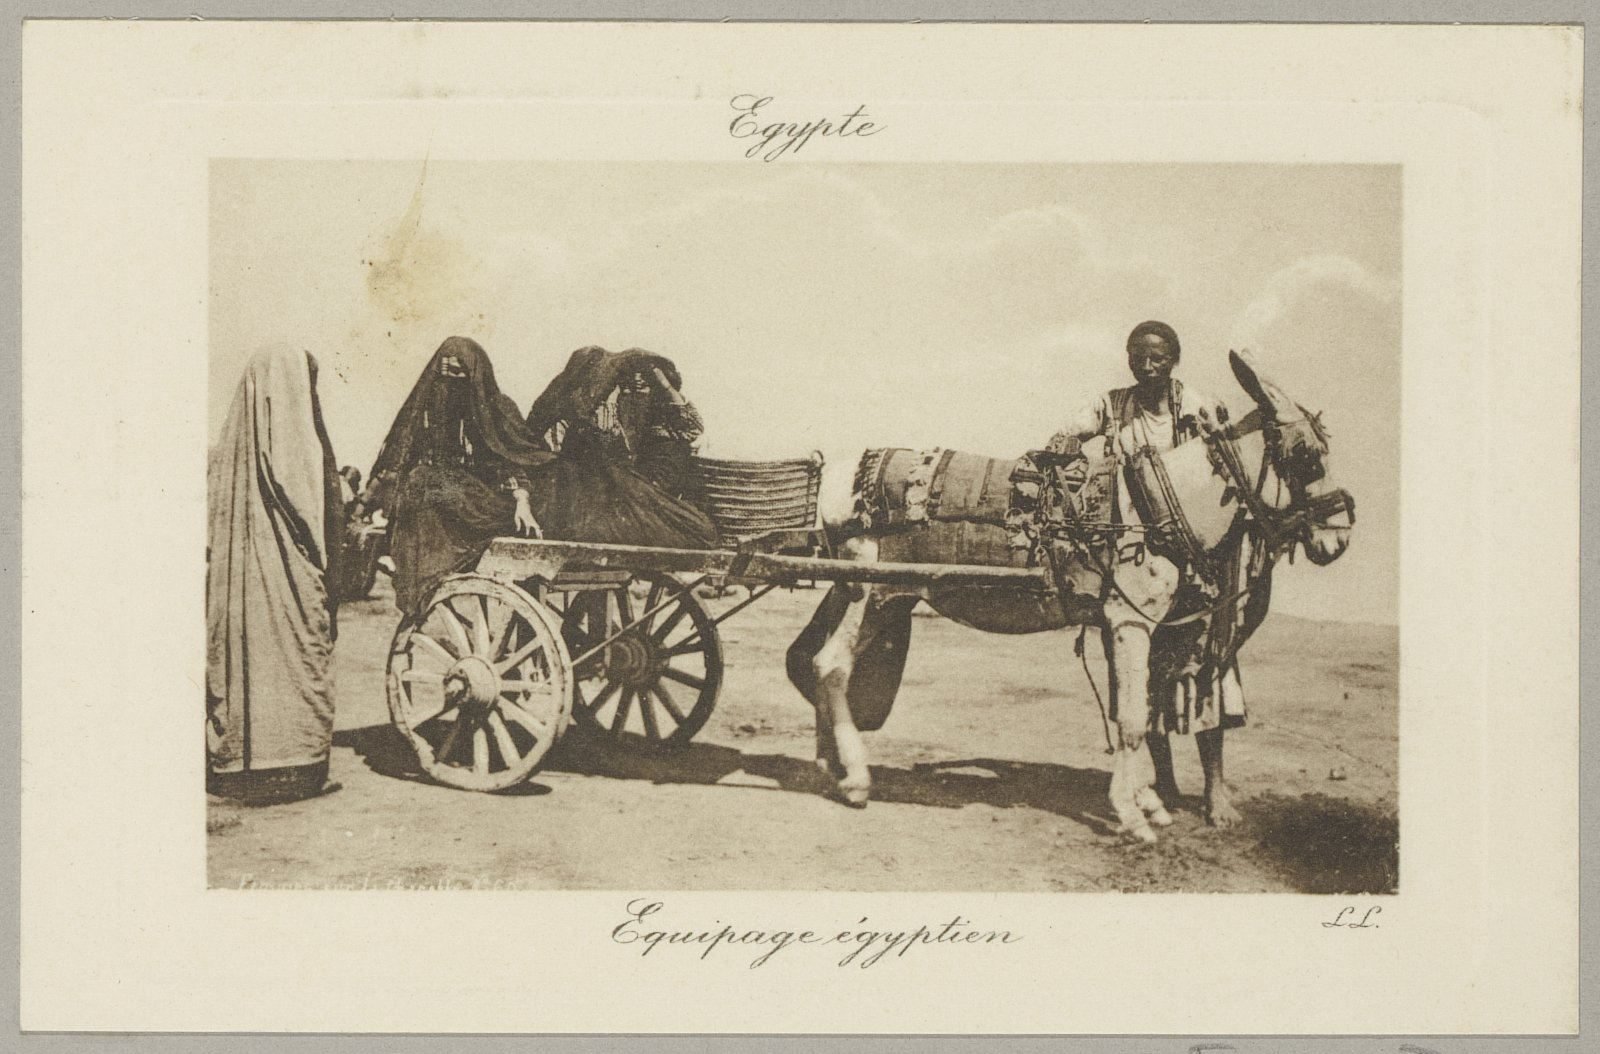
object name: photomechanical print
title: Equipage égyptien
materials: paper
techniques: photograph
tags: ass, donkey, two-wheeled, animal-drawn vehicle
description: Onderdeel van Fotoalbum van een reis door Zuid-Europa en het Midden-Oosten.